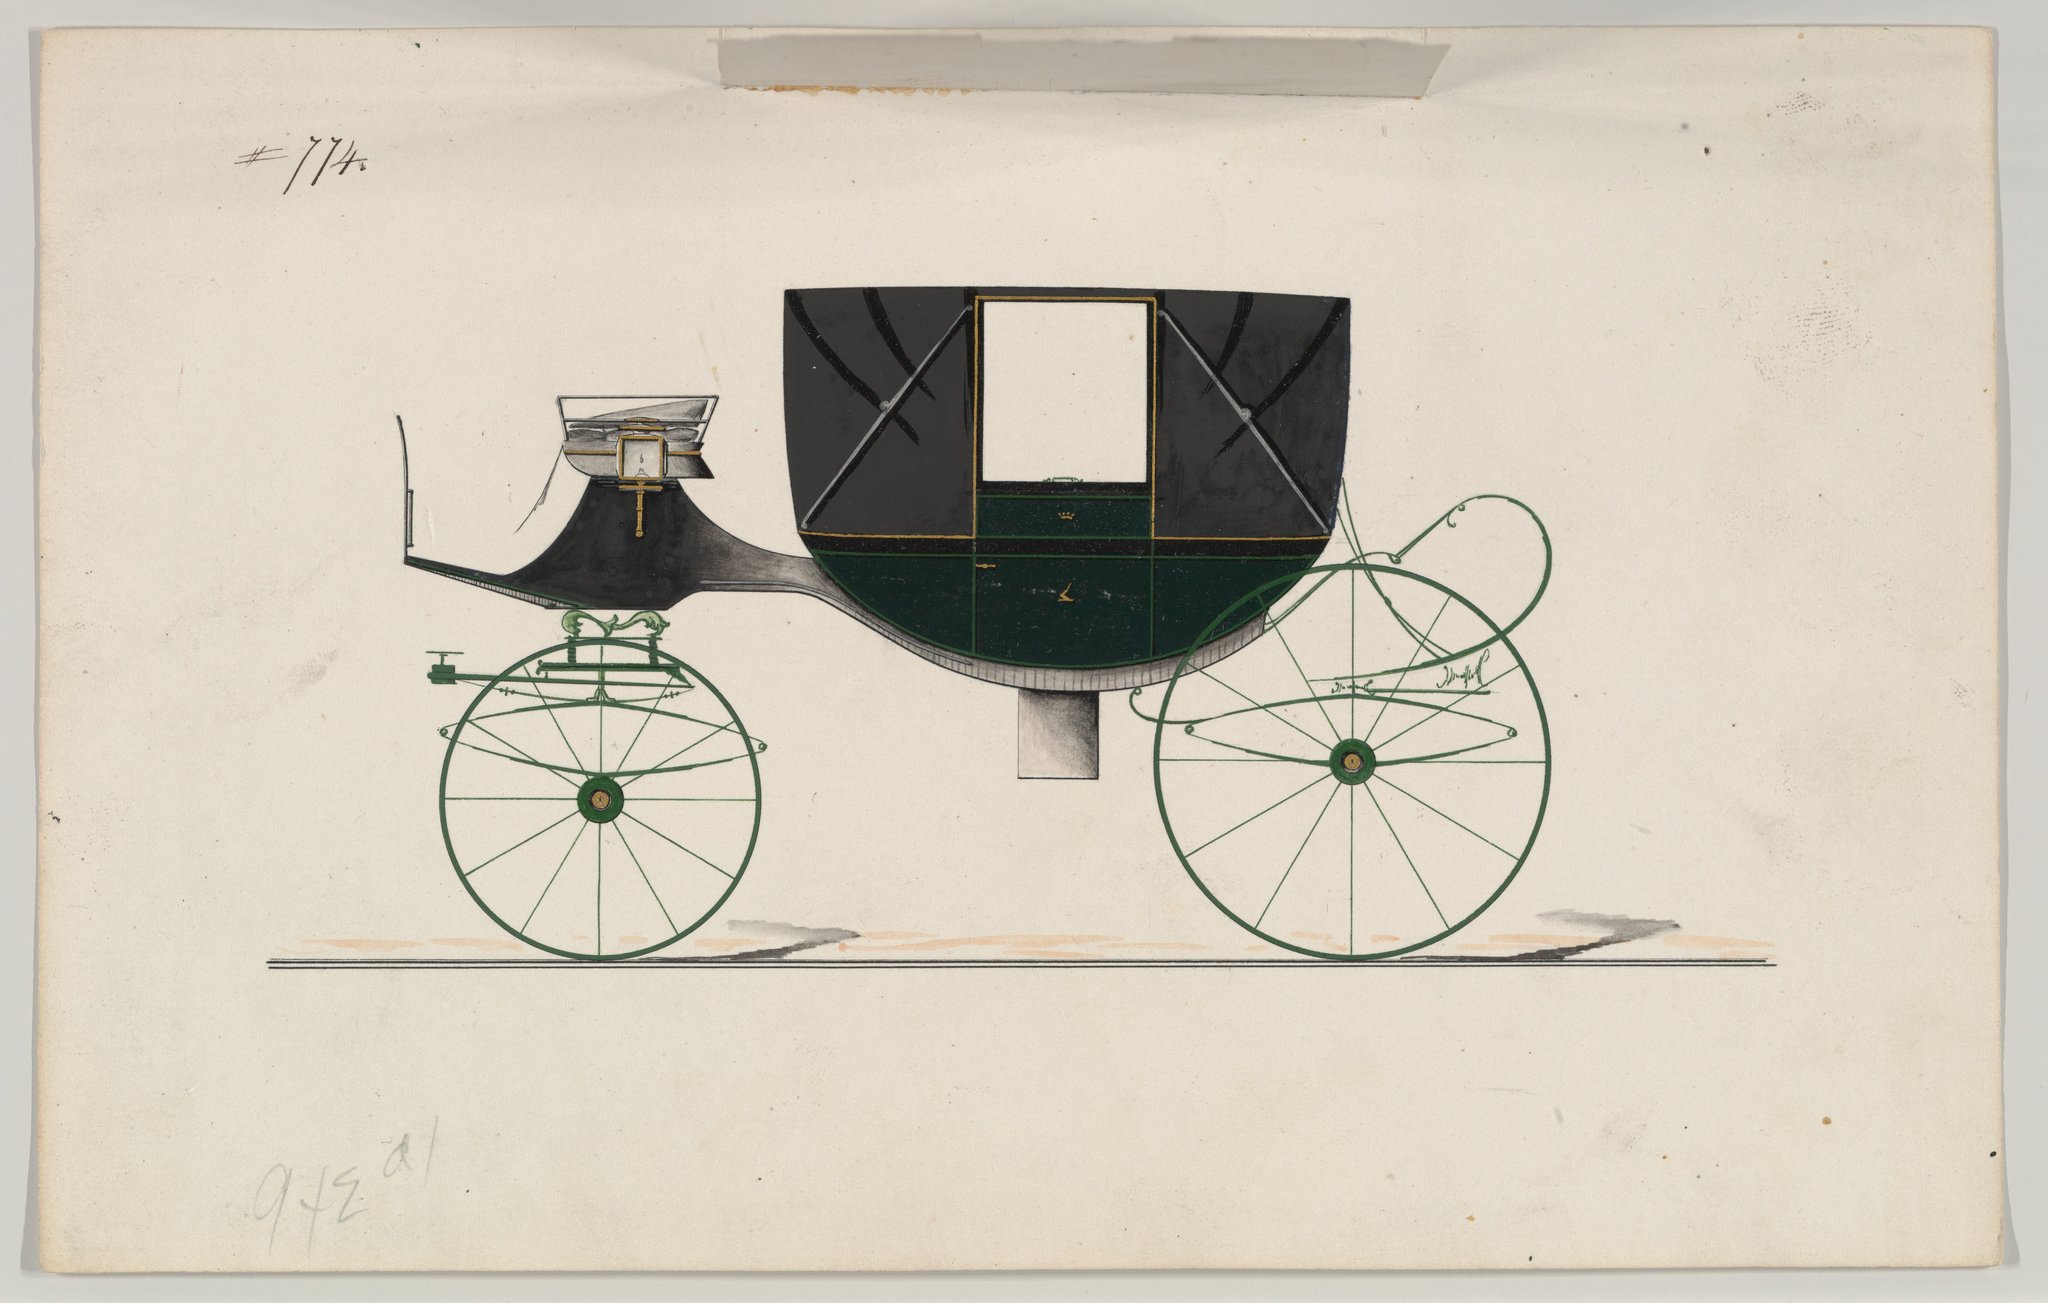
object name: drawing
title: Landau #774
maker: brewster & co.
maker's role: manufacturer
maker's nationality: american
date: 1850-1870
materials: gouache, gum arabic, ink, watercolor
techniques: pen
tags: carriages